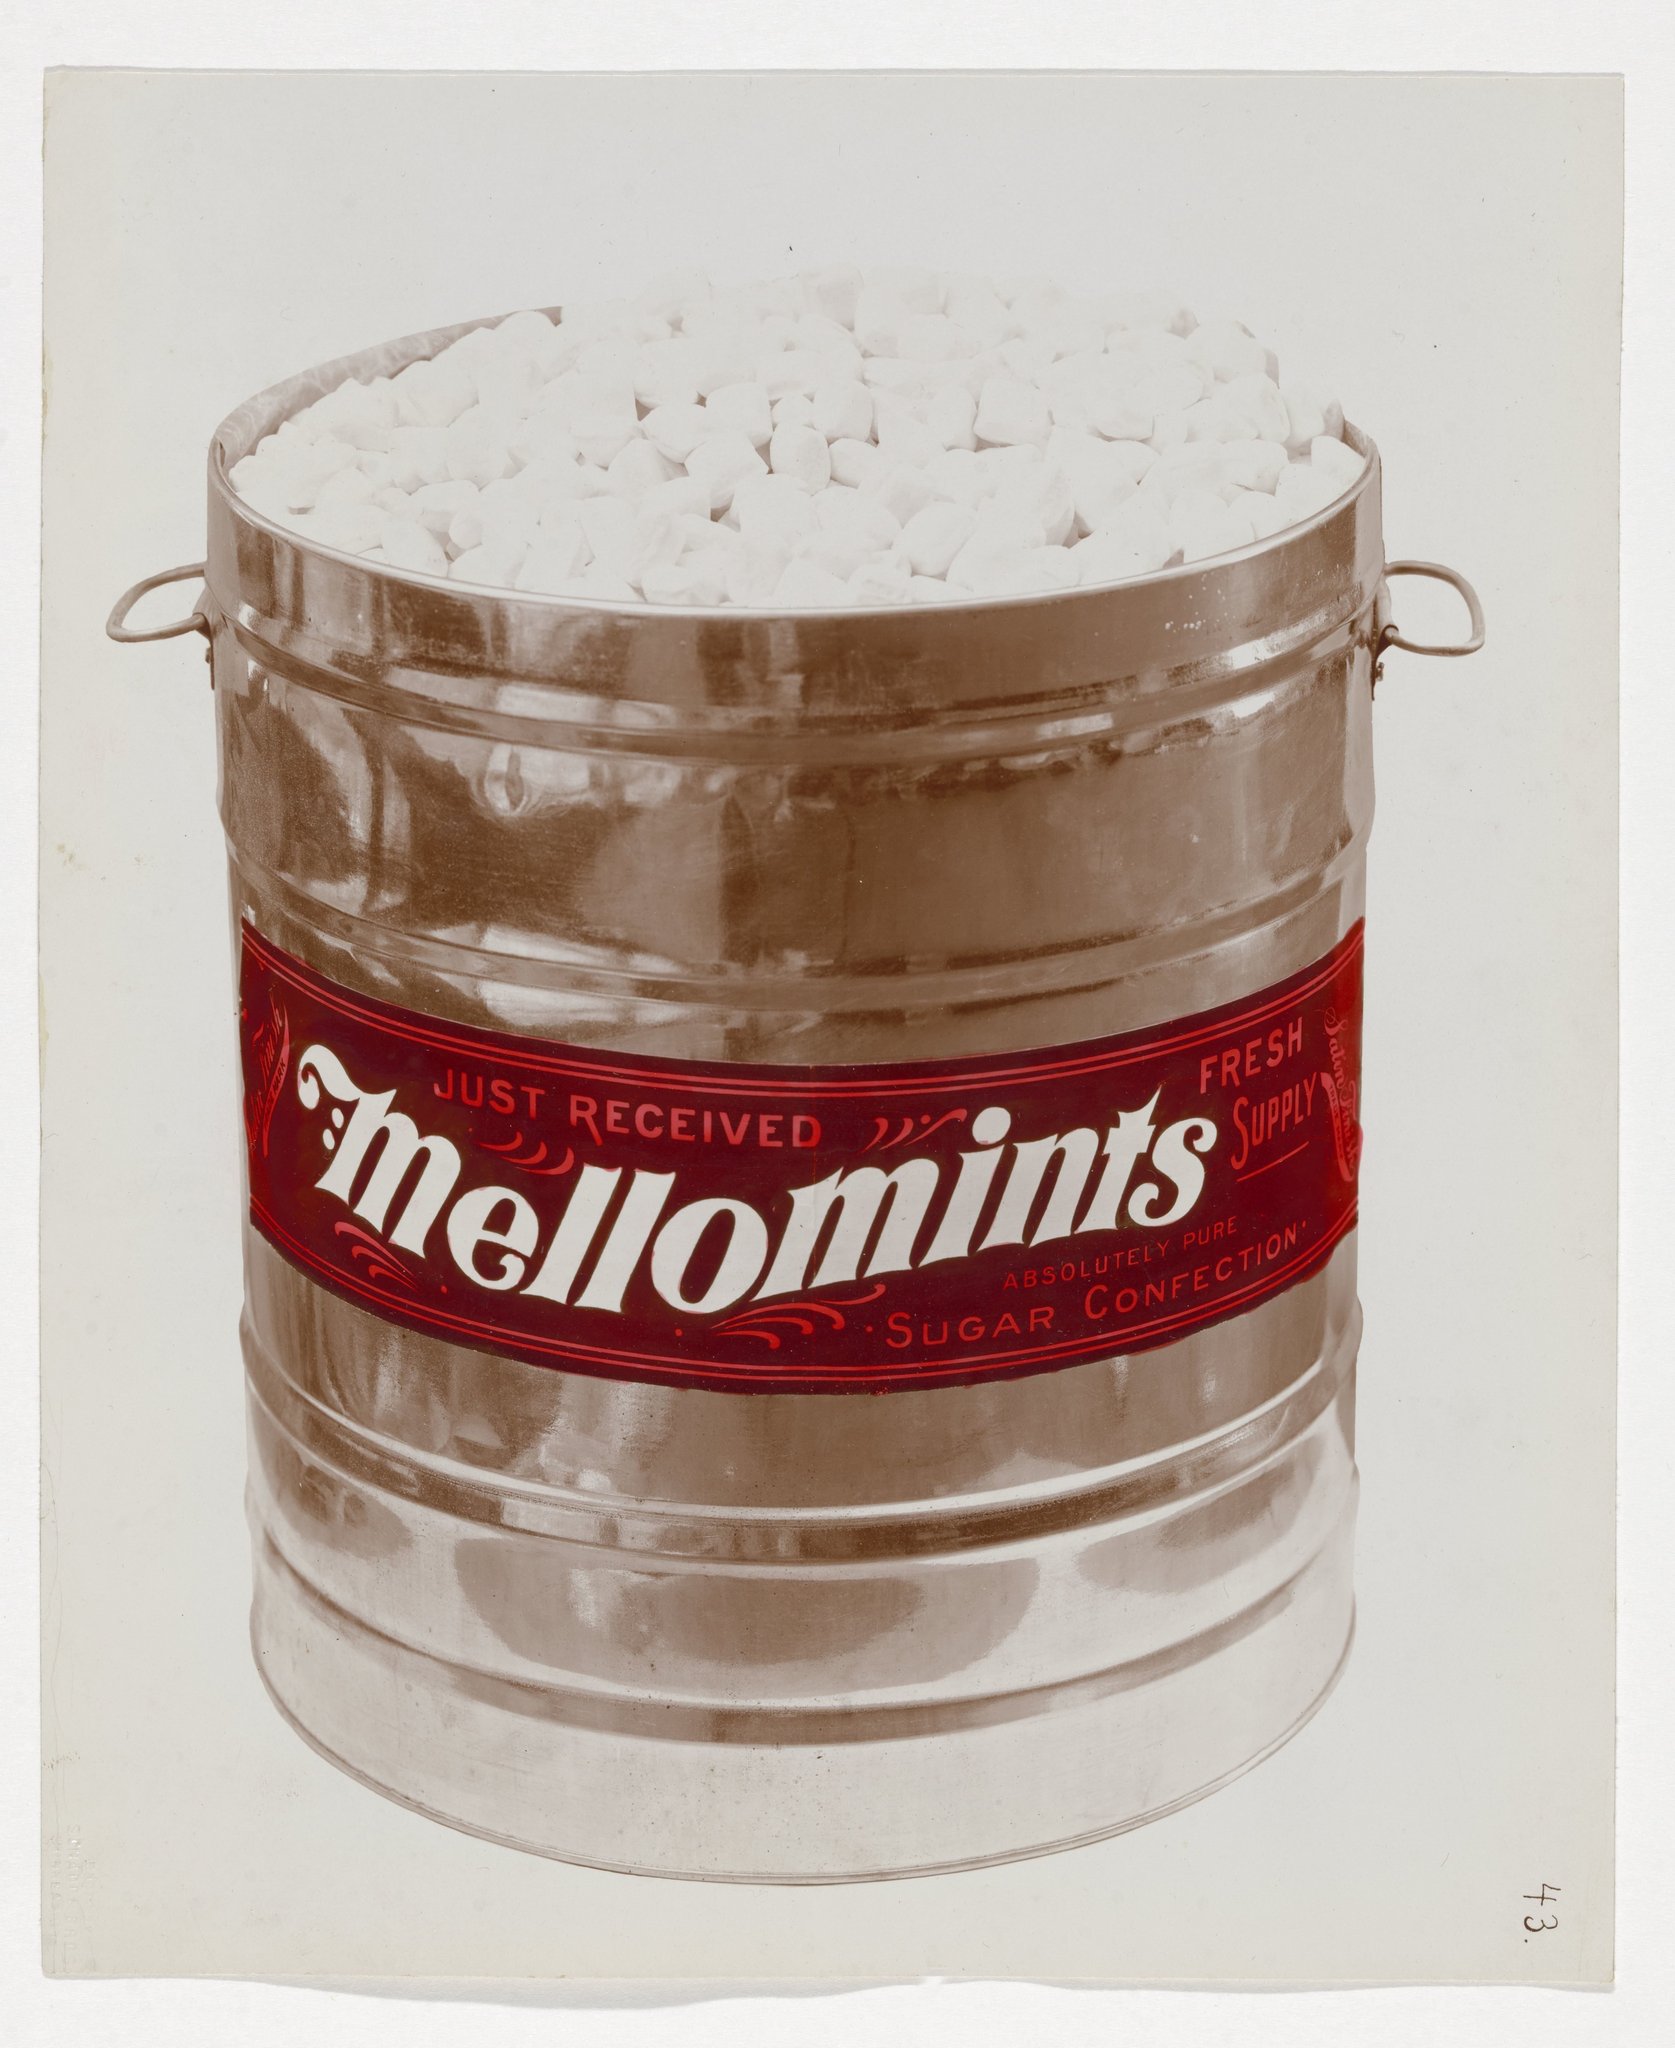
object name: photograph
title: Emmer met pepermunt, reclame voor snoepfabrikant Brandle and Smith Co., Philadelphia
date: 1915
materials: paper, paint, textile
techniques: hand coloring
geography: minneapolis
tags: advertising, sugar-candy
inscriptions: number: ‘43.’